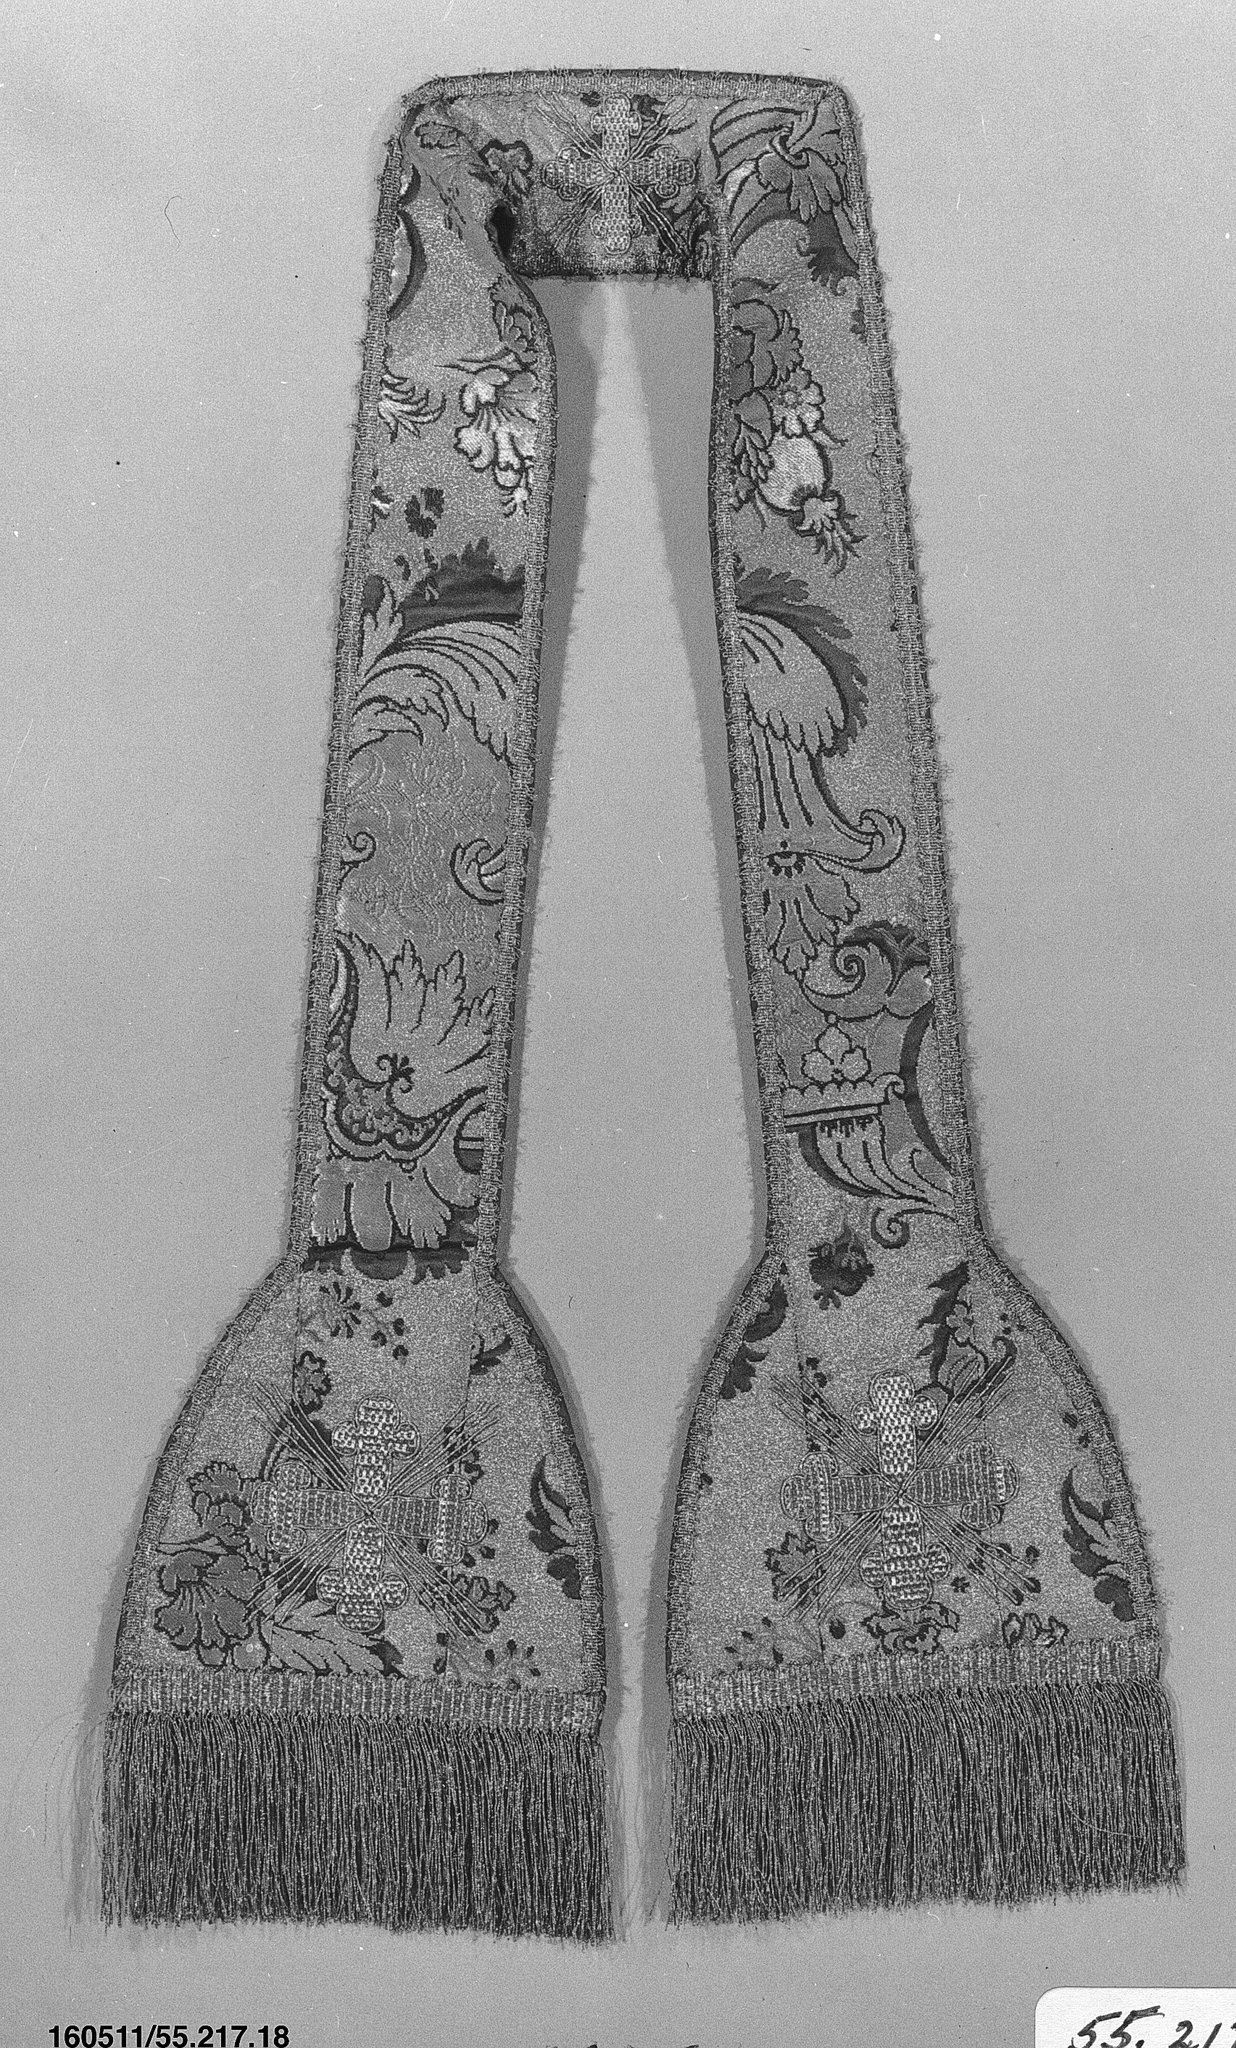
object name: maniple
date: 1720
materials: metal thread, silk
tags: flowers,leaves